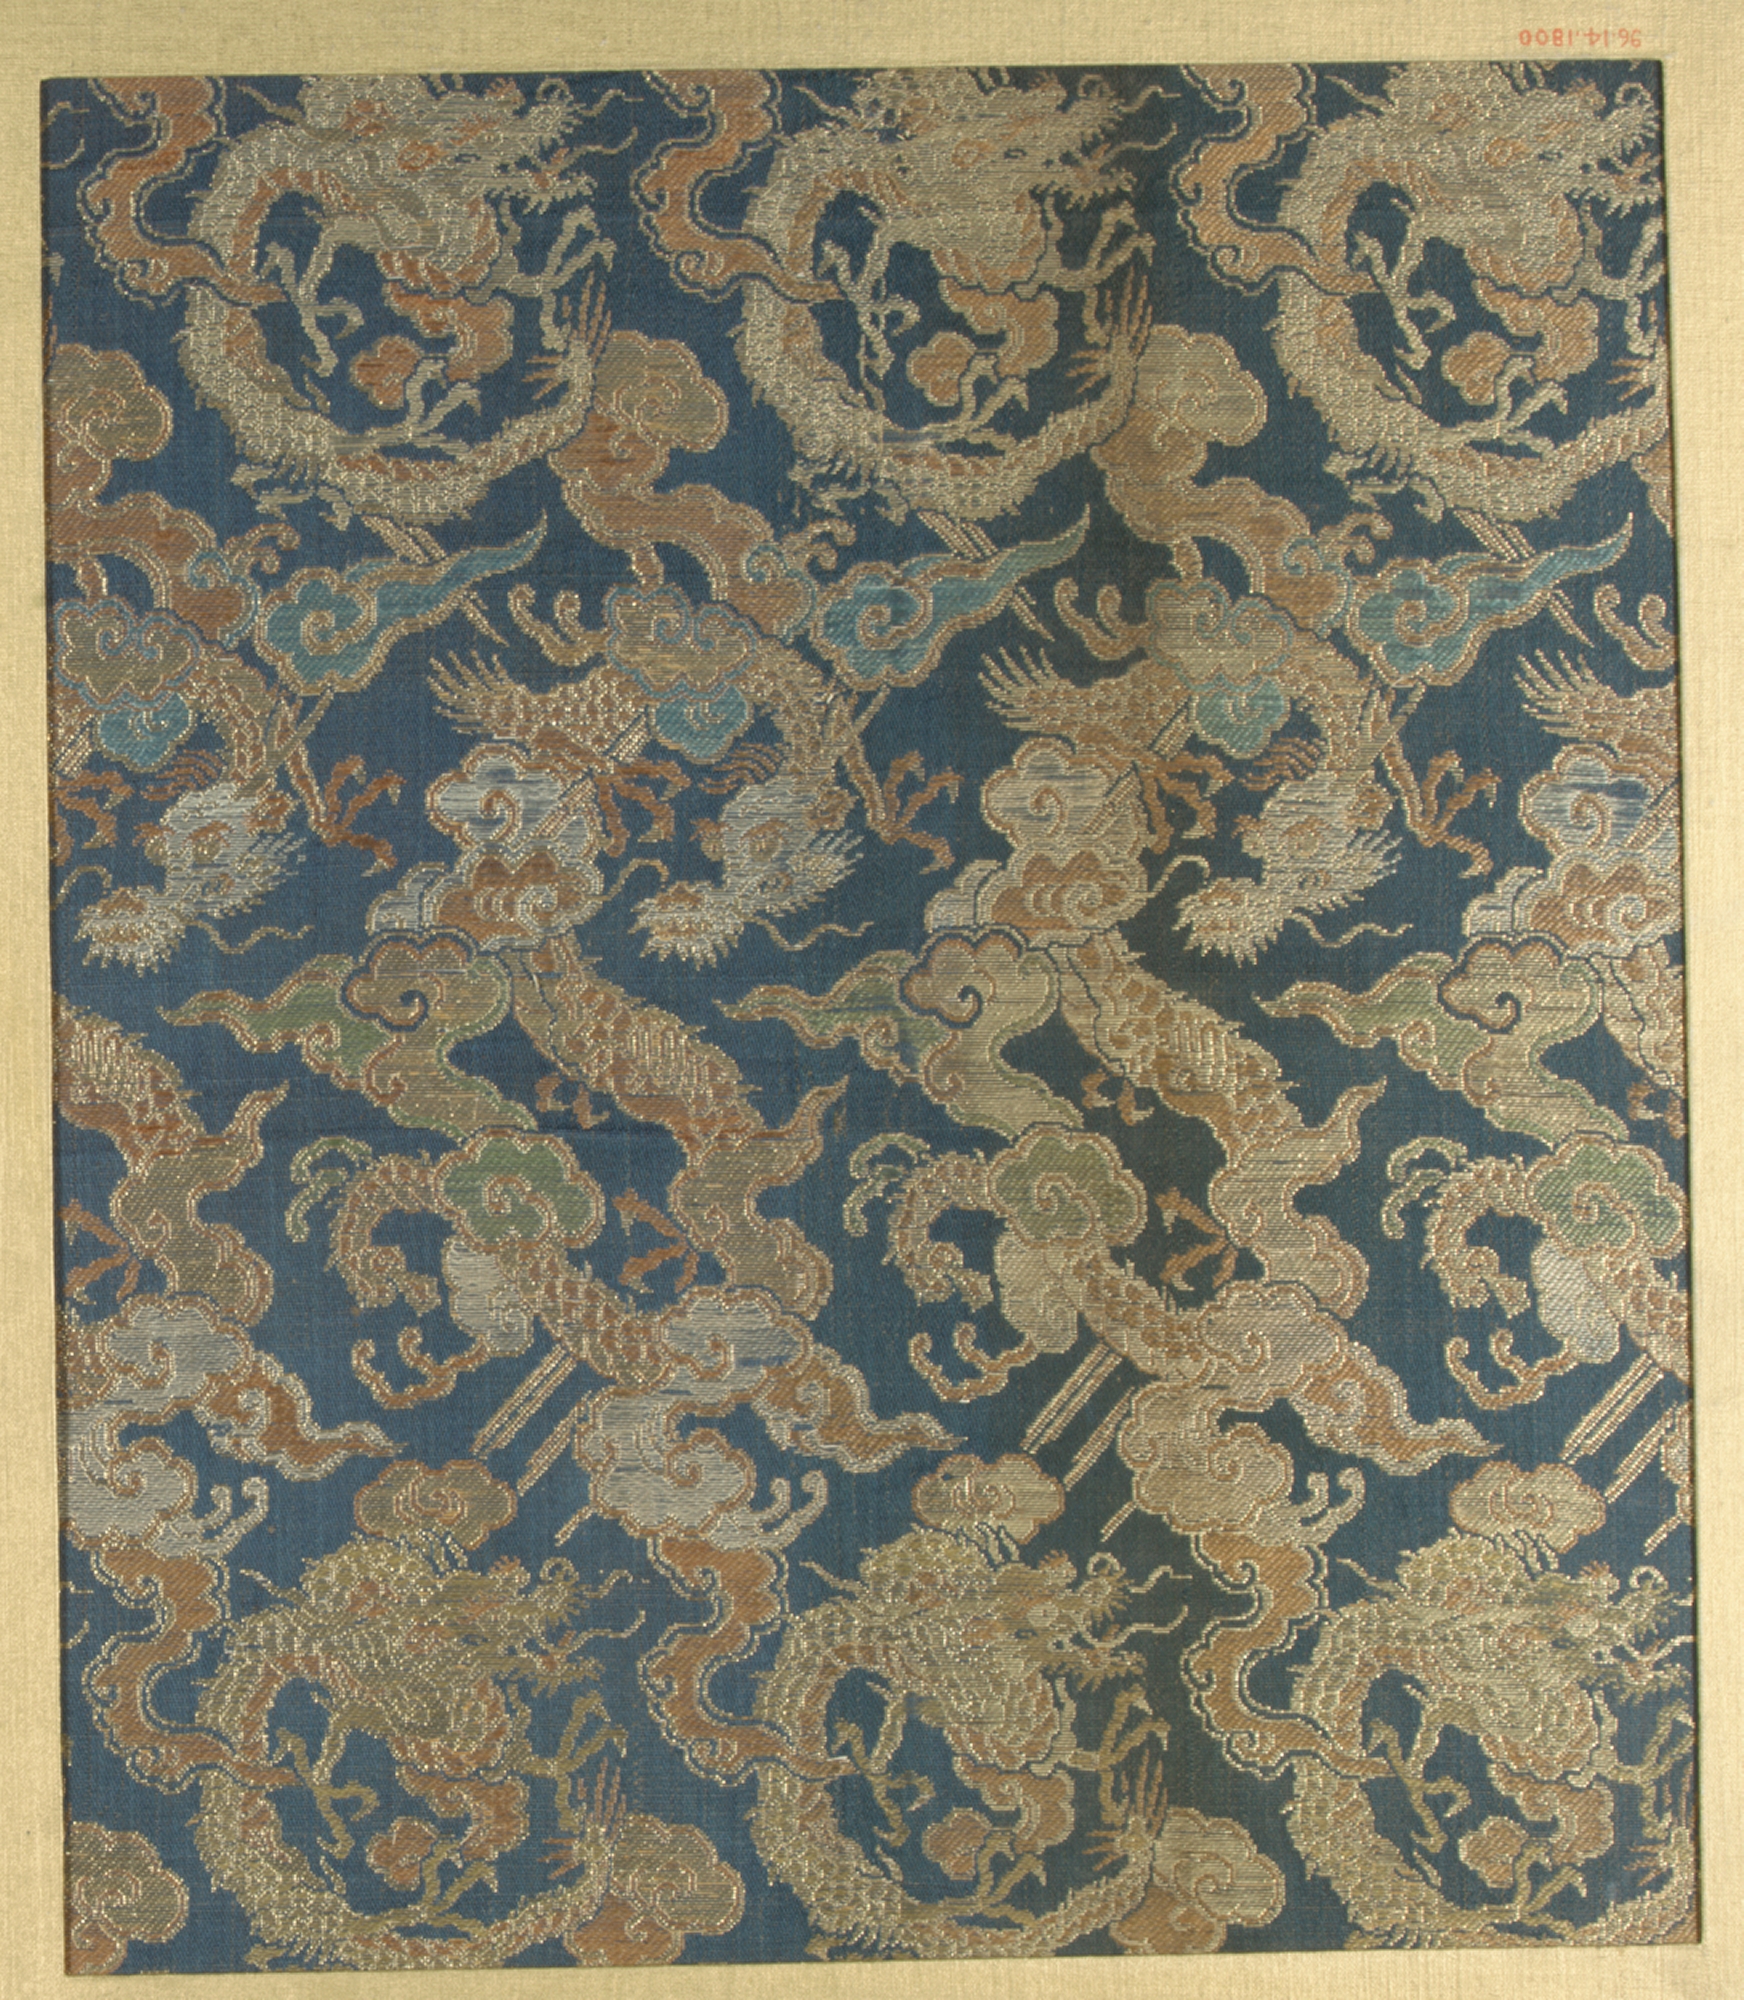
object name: piece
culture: japanese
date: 1701-1900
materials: silk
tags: dragons